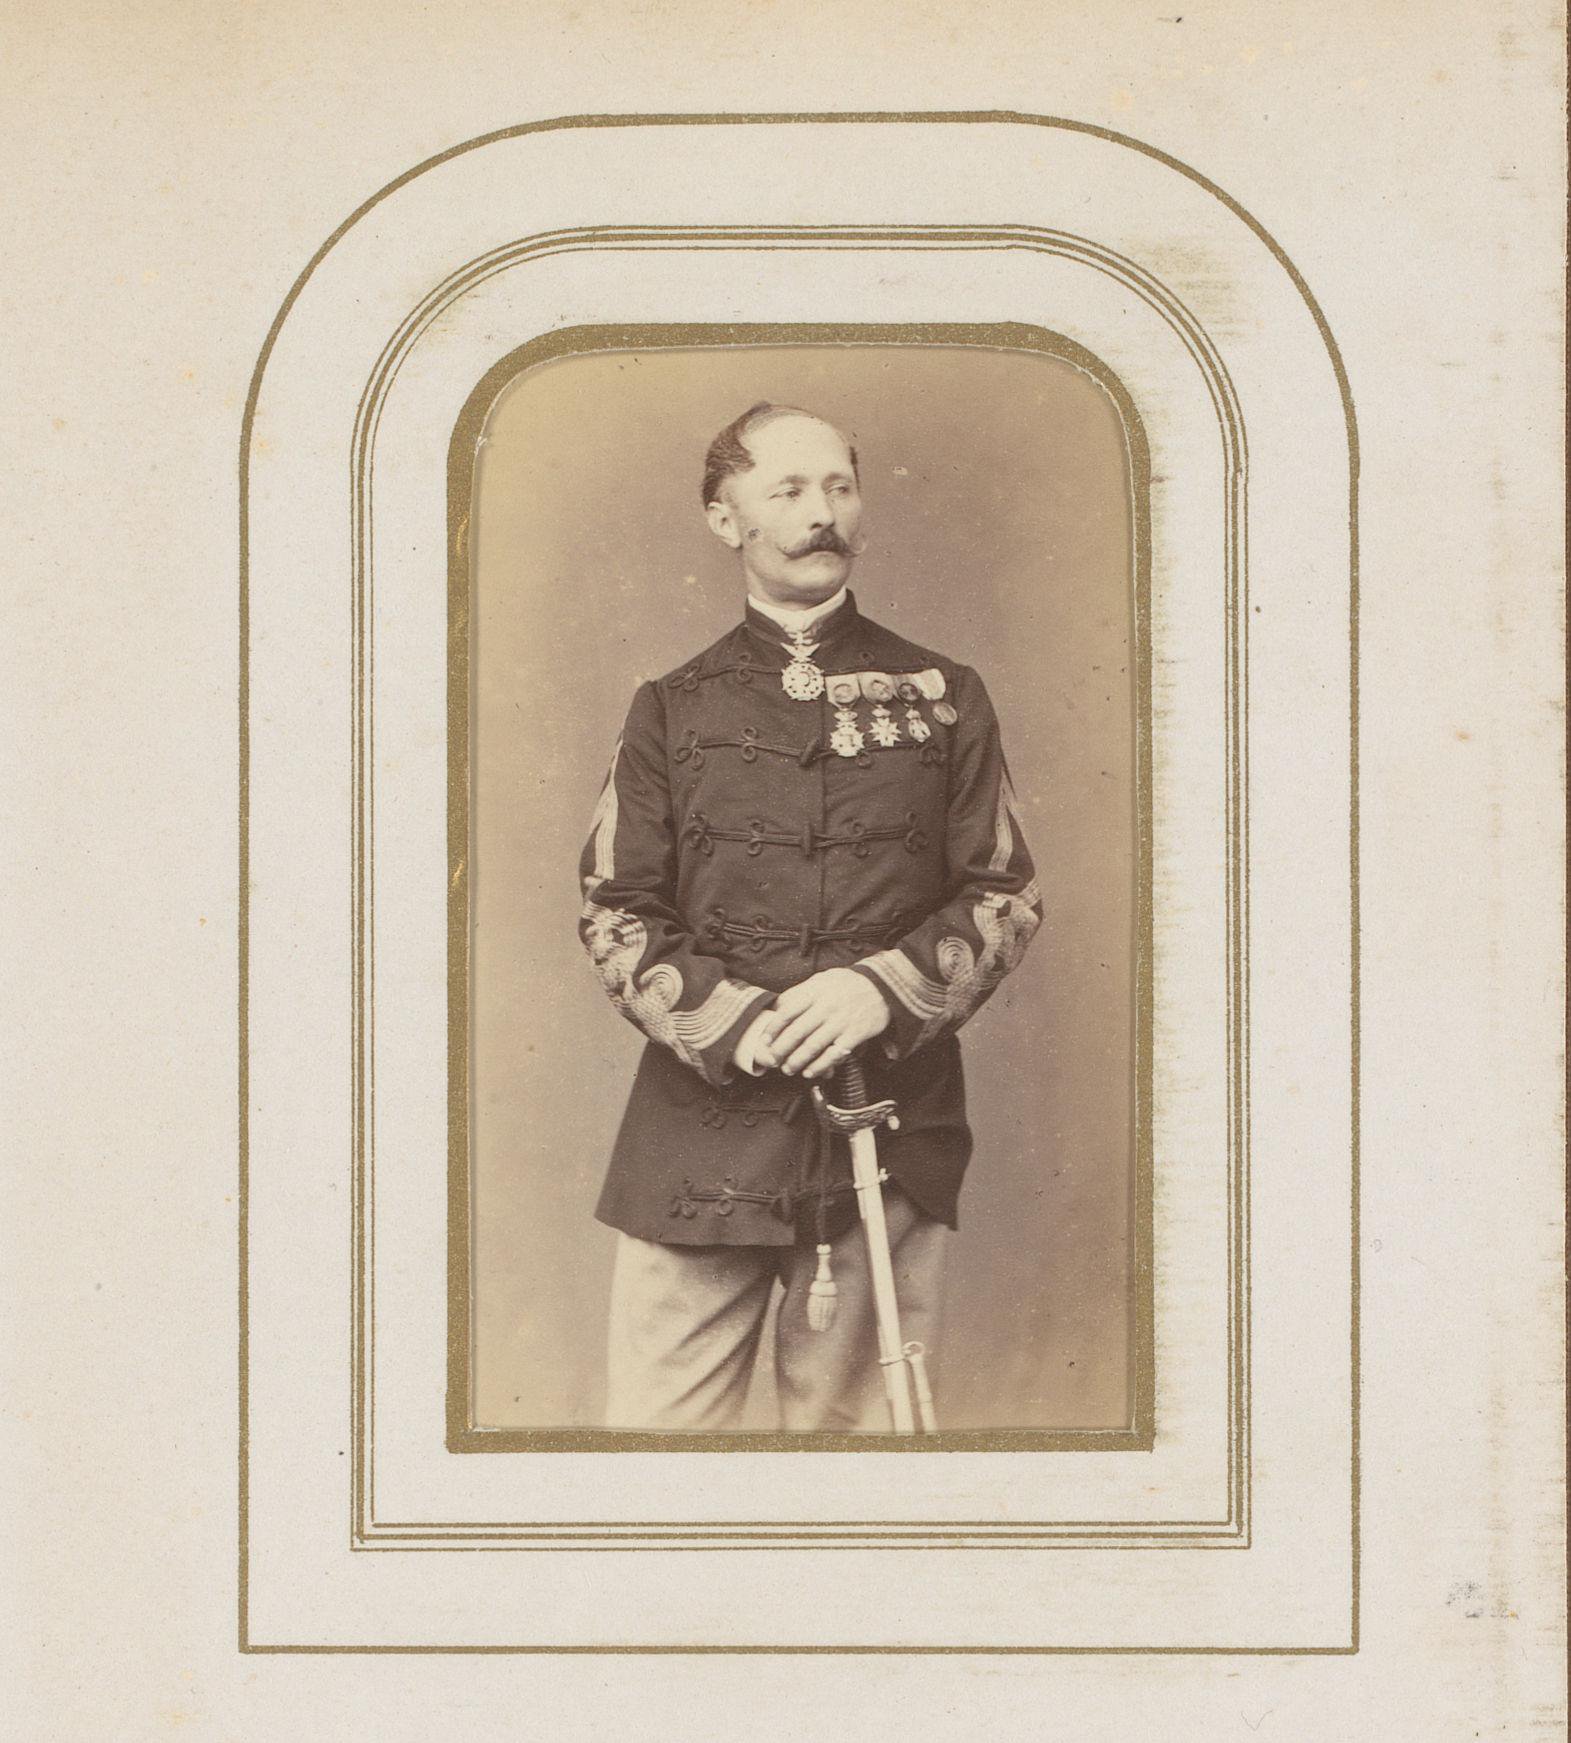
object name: carte de visite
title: Portret van een man met zwaard in uniform met medailles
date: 1860-1894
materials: cardboard, photographic support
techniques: albumen print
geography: brussels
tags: historical persons, hacking and thrusting weapons: sword, medals and other marks of military honour, (military) uniforms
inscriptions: inscription: ‘Ghémar Frères/ Photographes du roi/ 27, rue de l'Ecruyer/ entree par la porte cochère/ Bruxelles’